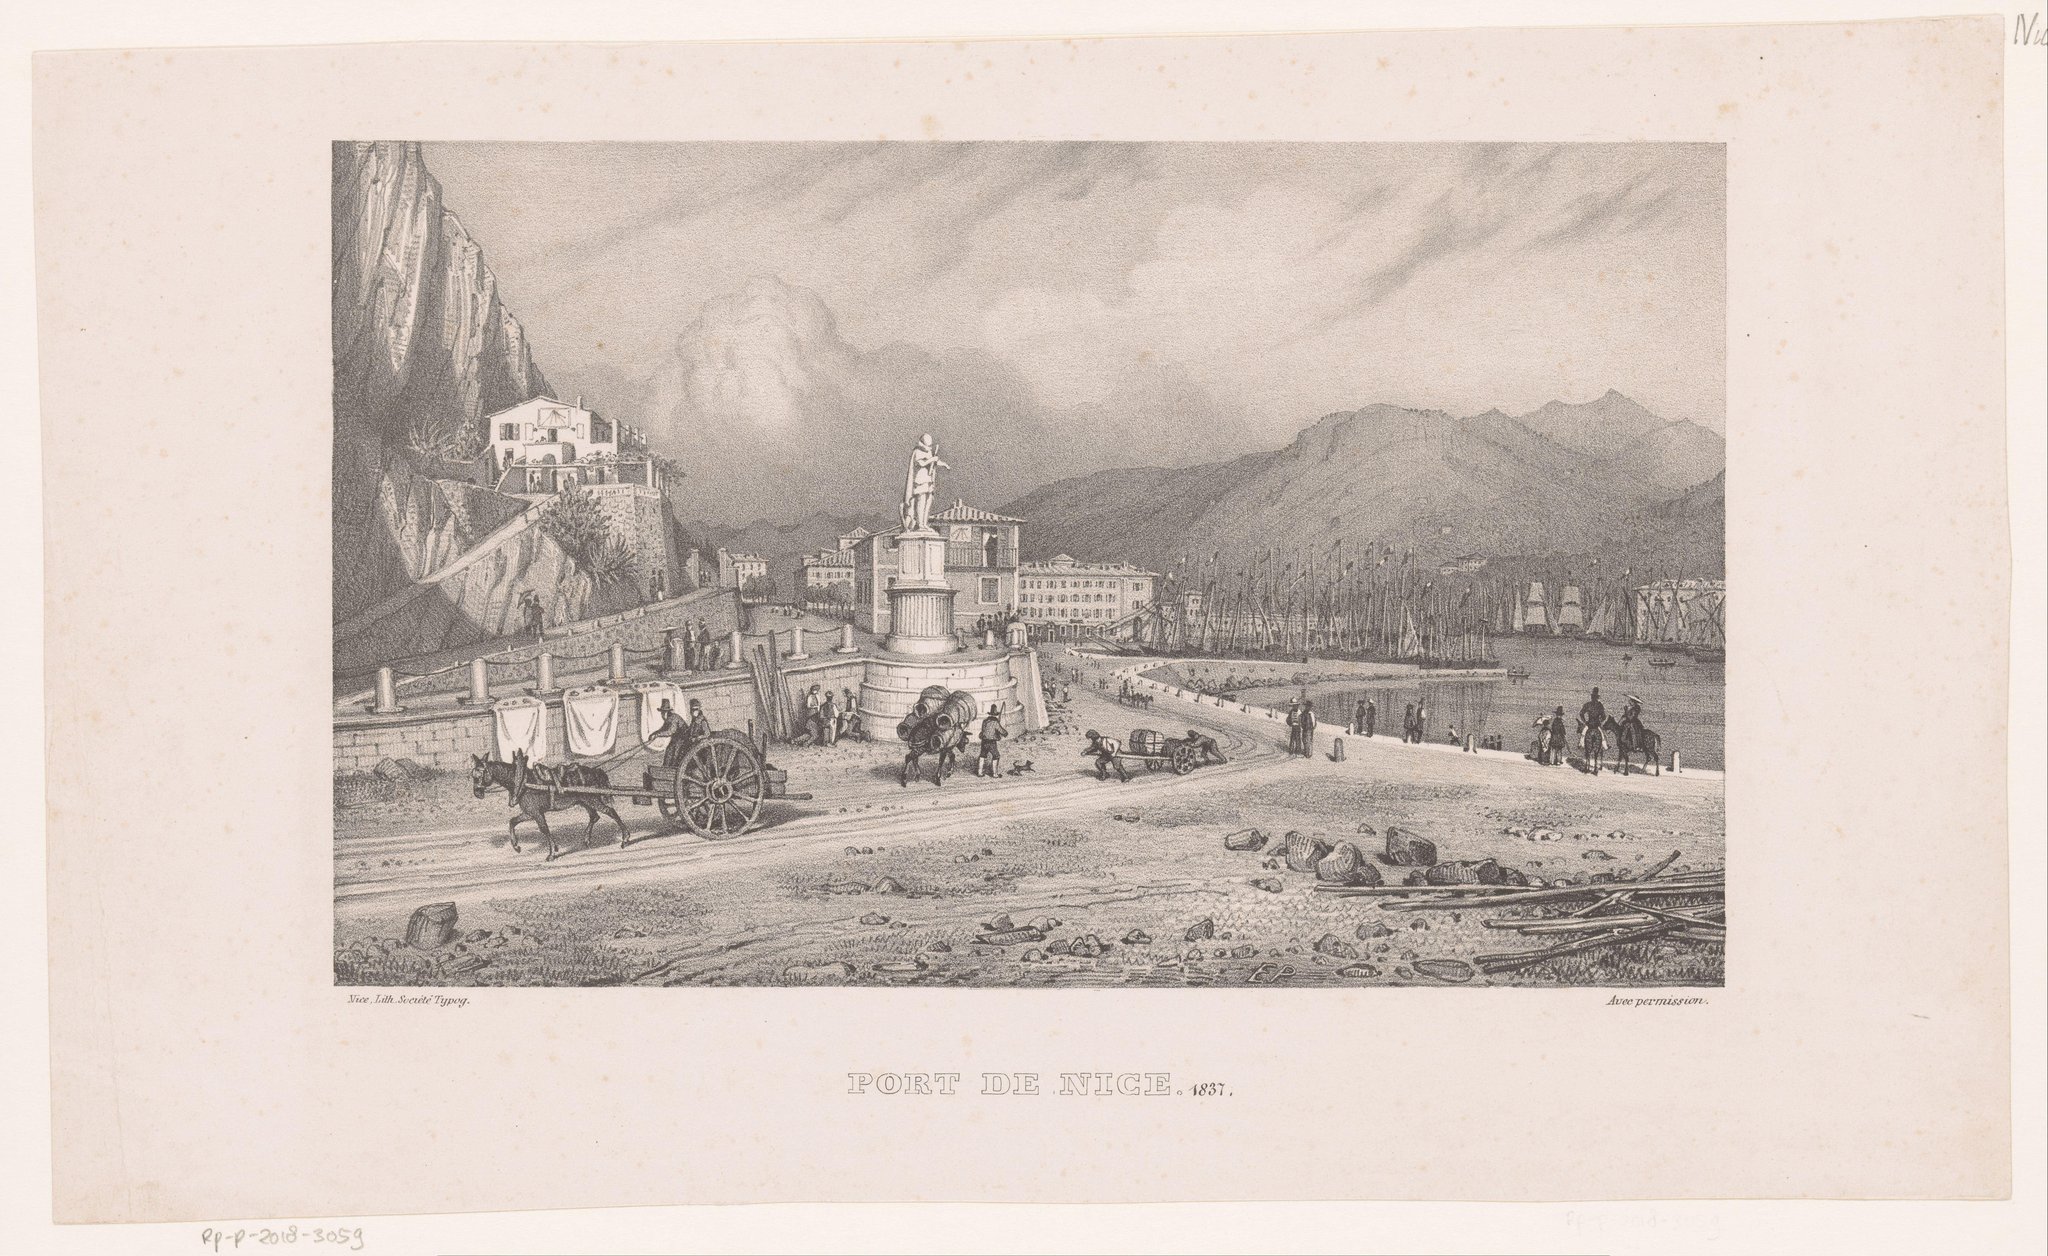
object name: print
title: Port de Nice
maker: Anonymous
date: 1837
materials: paper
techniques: lithograph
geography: nice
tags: harbour, city-view, and landscape with man-made constructions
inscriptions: monogram: ‘EP’, collector's mark: Lugt 2228, : ‘Avec permission.’